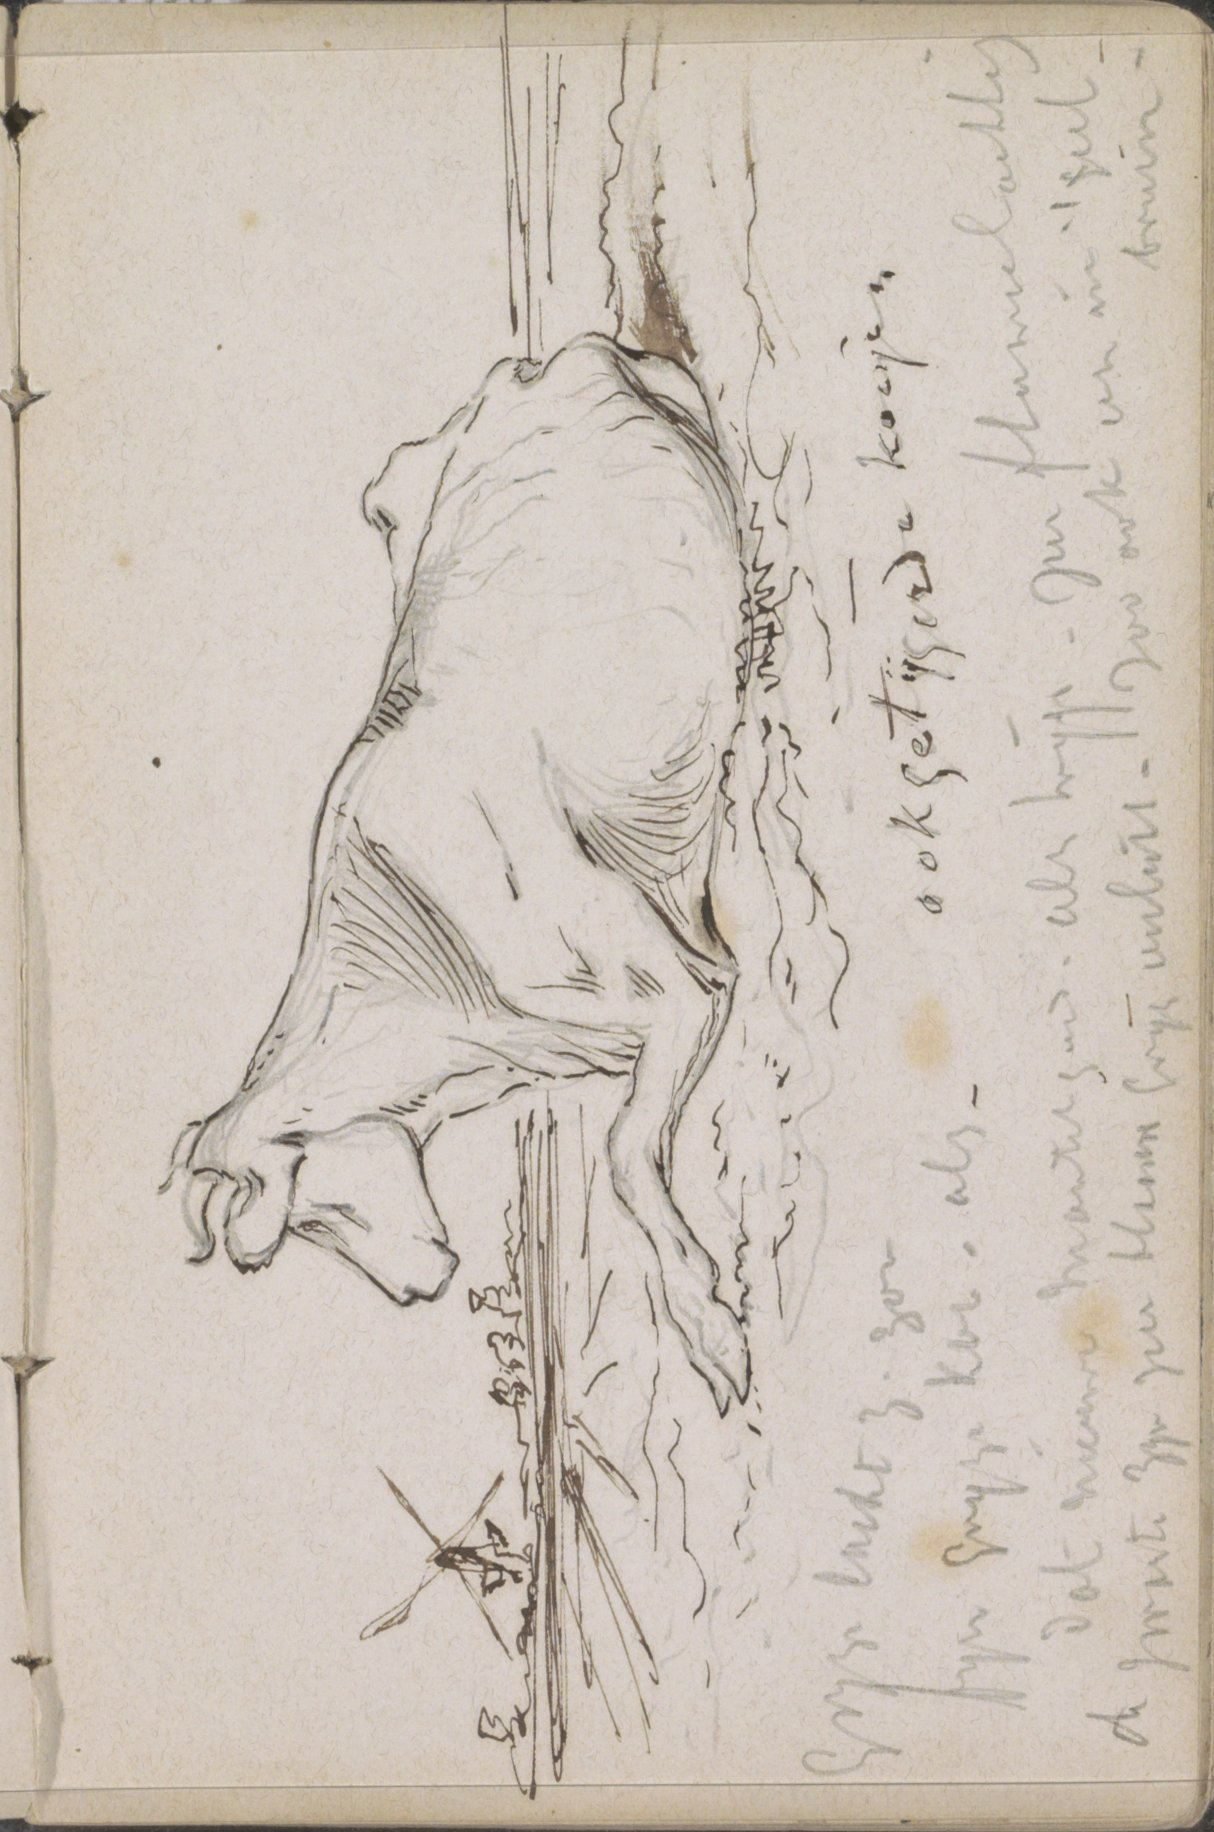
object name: sketchbook leaf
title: Landschap met een liggende koe en een molen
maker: johannes tavenraat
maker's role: draughtsman, painter, print maker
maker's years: 1809-1881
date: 1862-1864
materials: ink, paper, pencil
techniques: pen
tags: cow, meadow, pasture, windmill in landscape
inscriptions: annotation: ‘ook getijgerde koeien’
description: Blad 17 recto uit een schetsboek met 65 bladen.